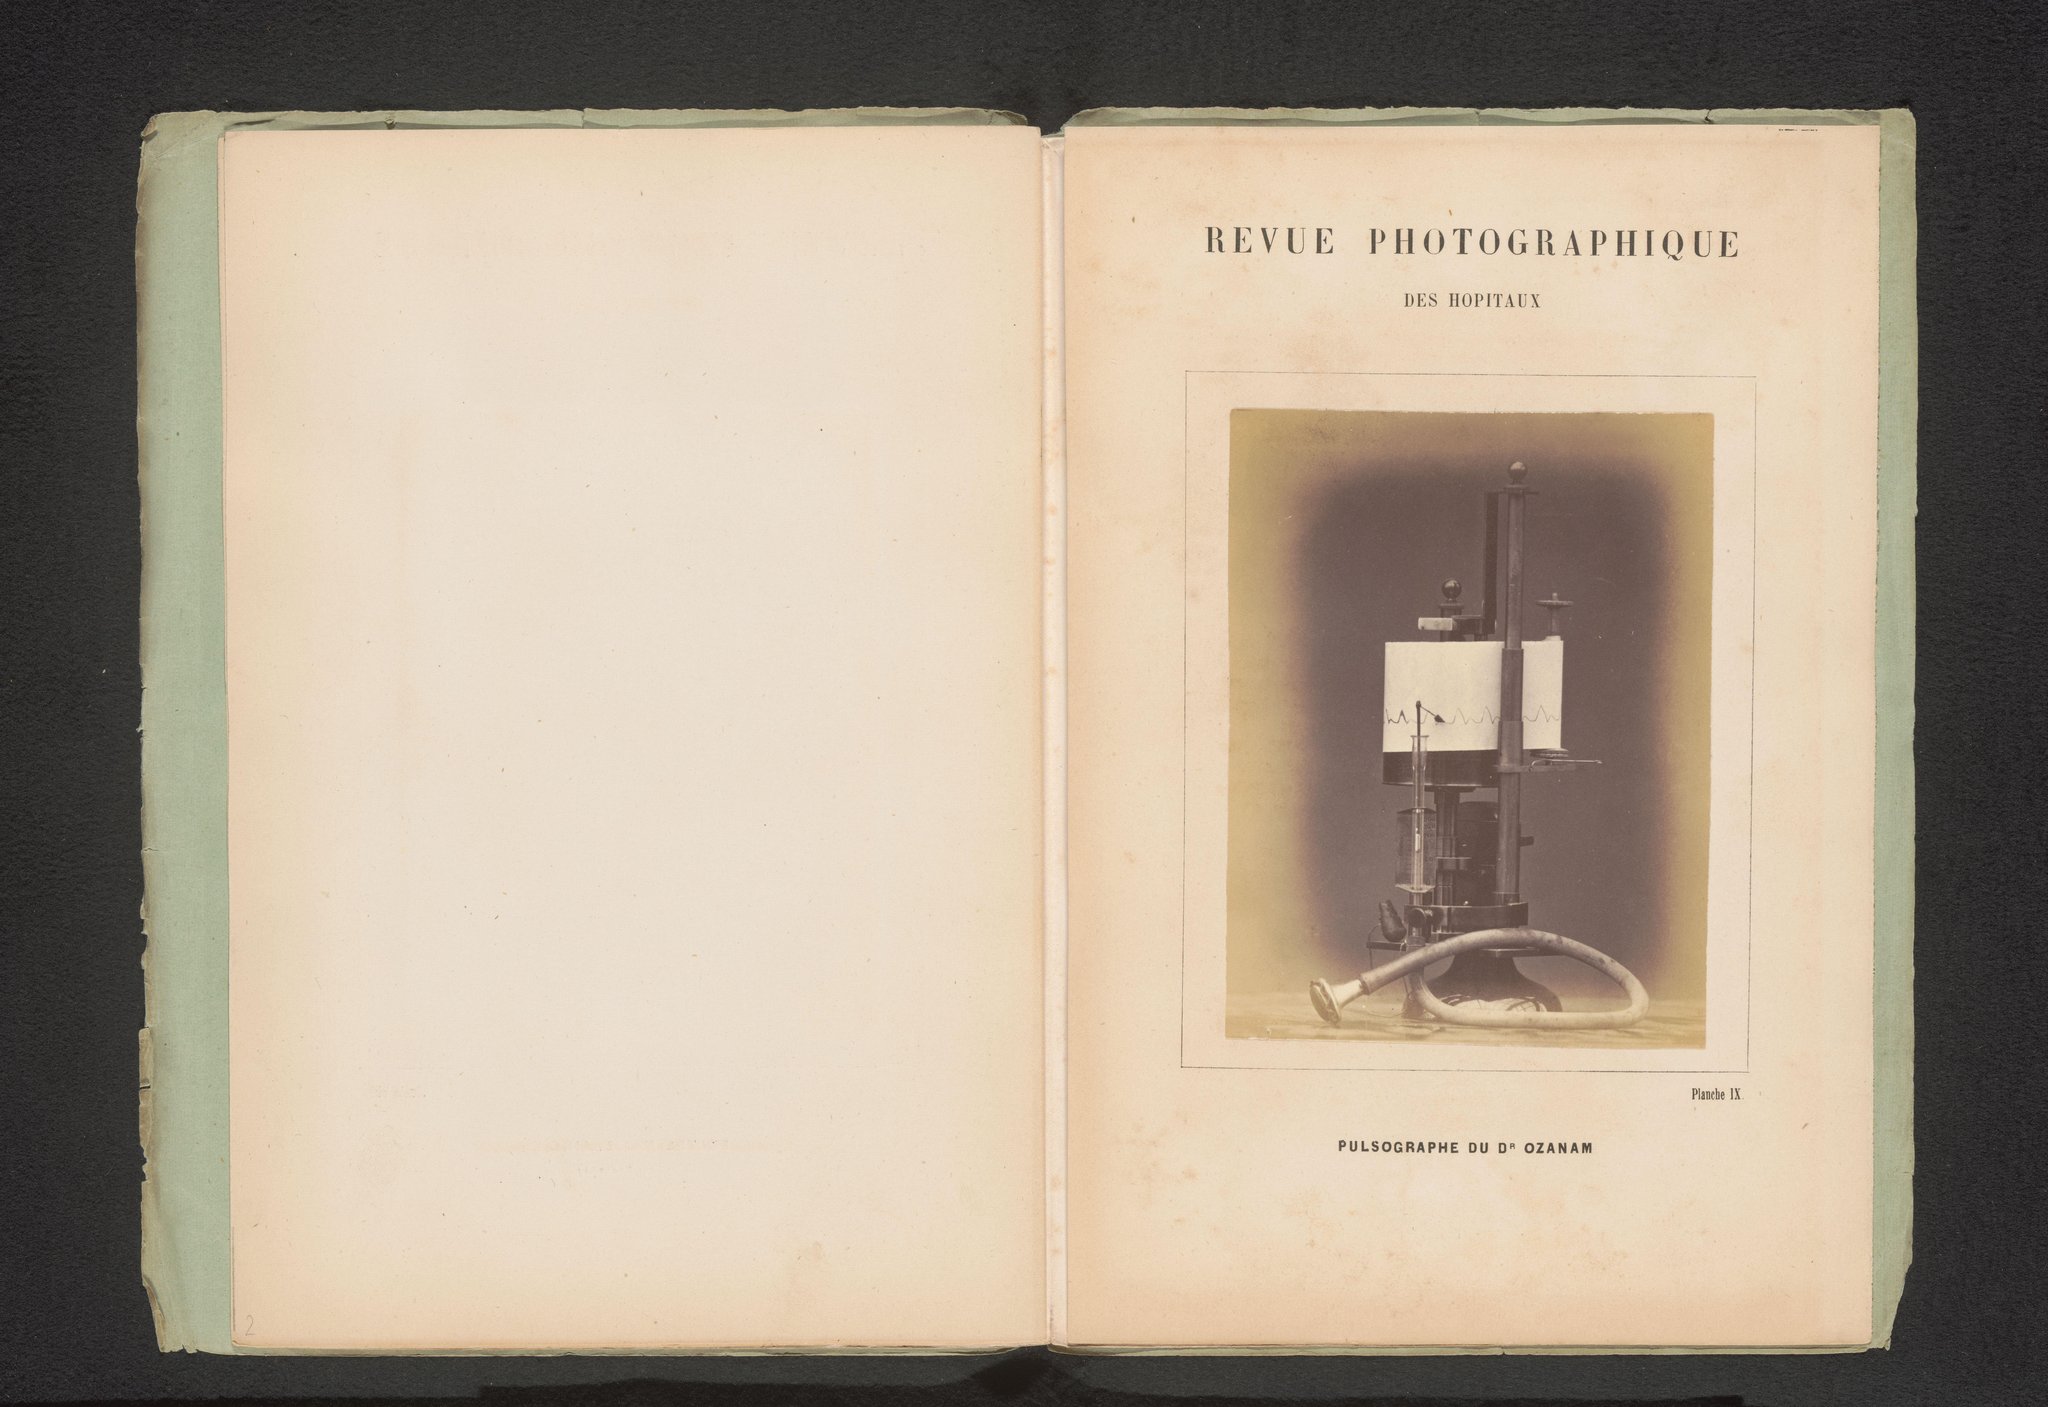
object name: page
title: Pulsmeter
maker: Anonymous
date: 1865-1870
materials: paper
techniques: albumen print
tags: medicine, medical science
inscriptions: inscription: ‘Revue photographique/ des hopitaux/ Planche IX.’